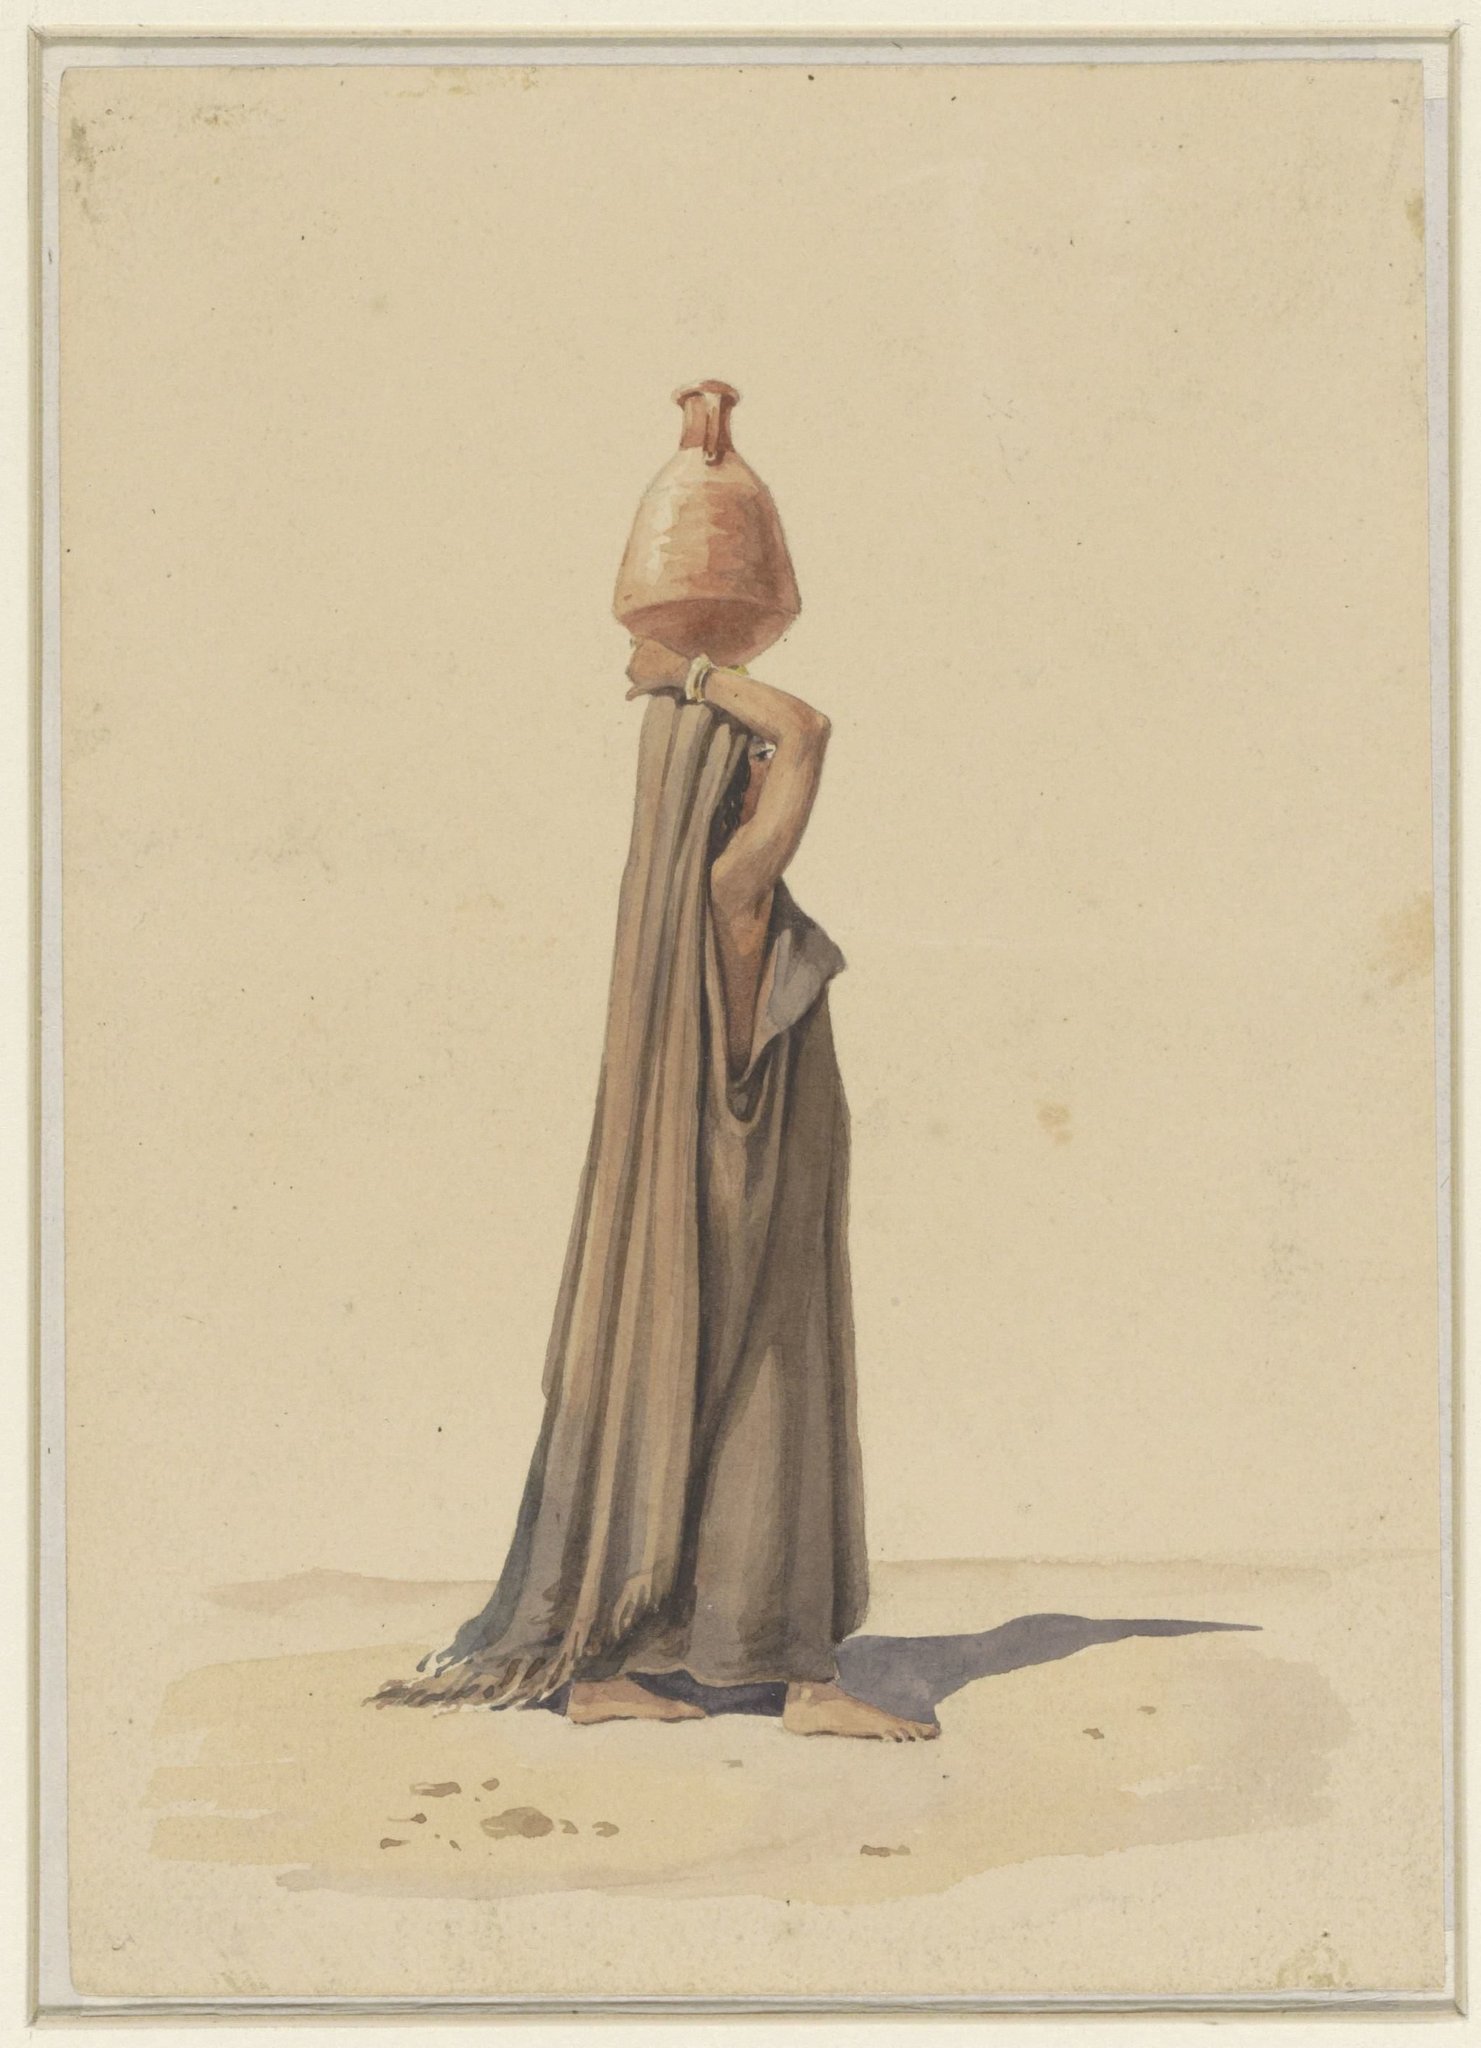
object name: drawing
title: Waterdraagster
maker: émile prisse davennes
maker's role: draughtsman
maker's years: 1830-1879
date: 1840-1879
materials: paper, watercolor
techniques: brush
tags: carrying something on the head or on the shoulders